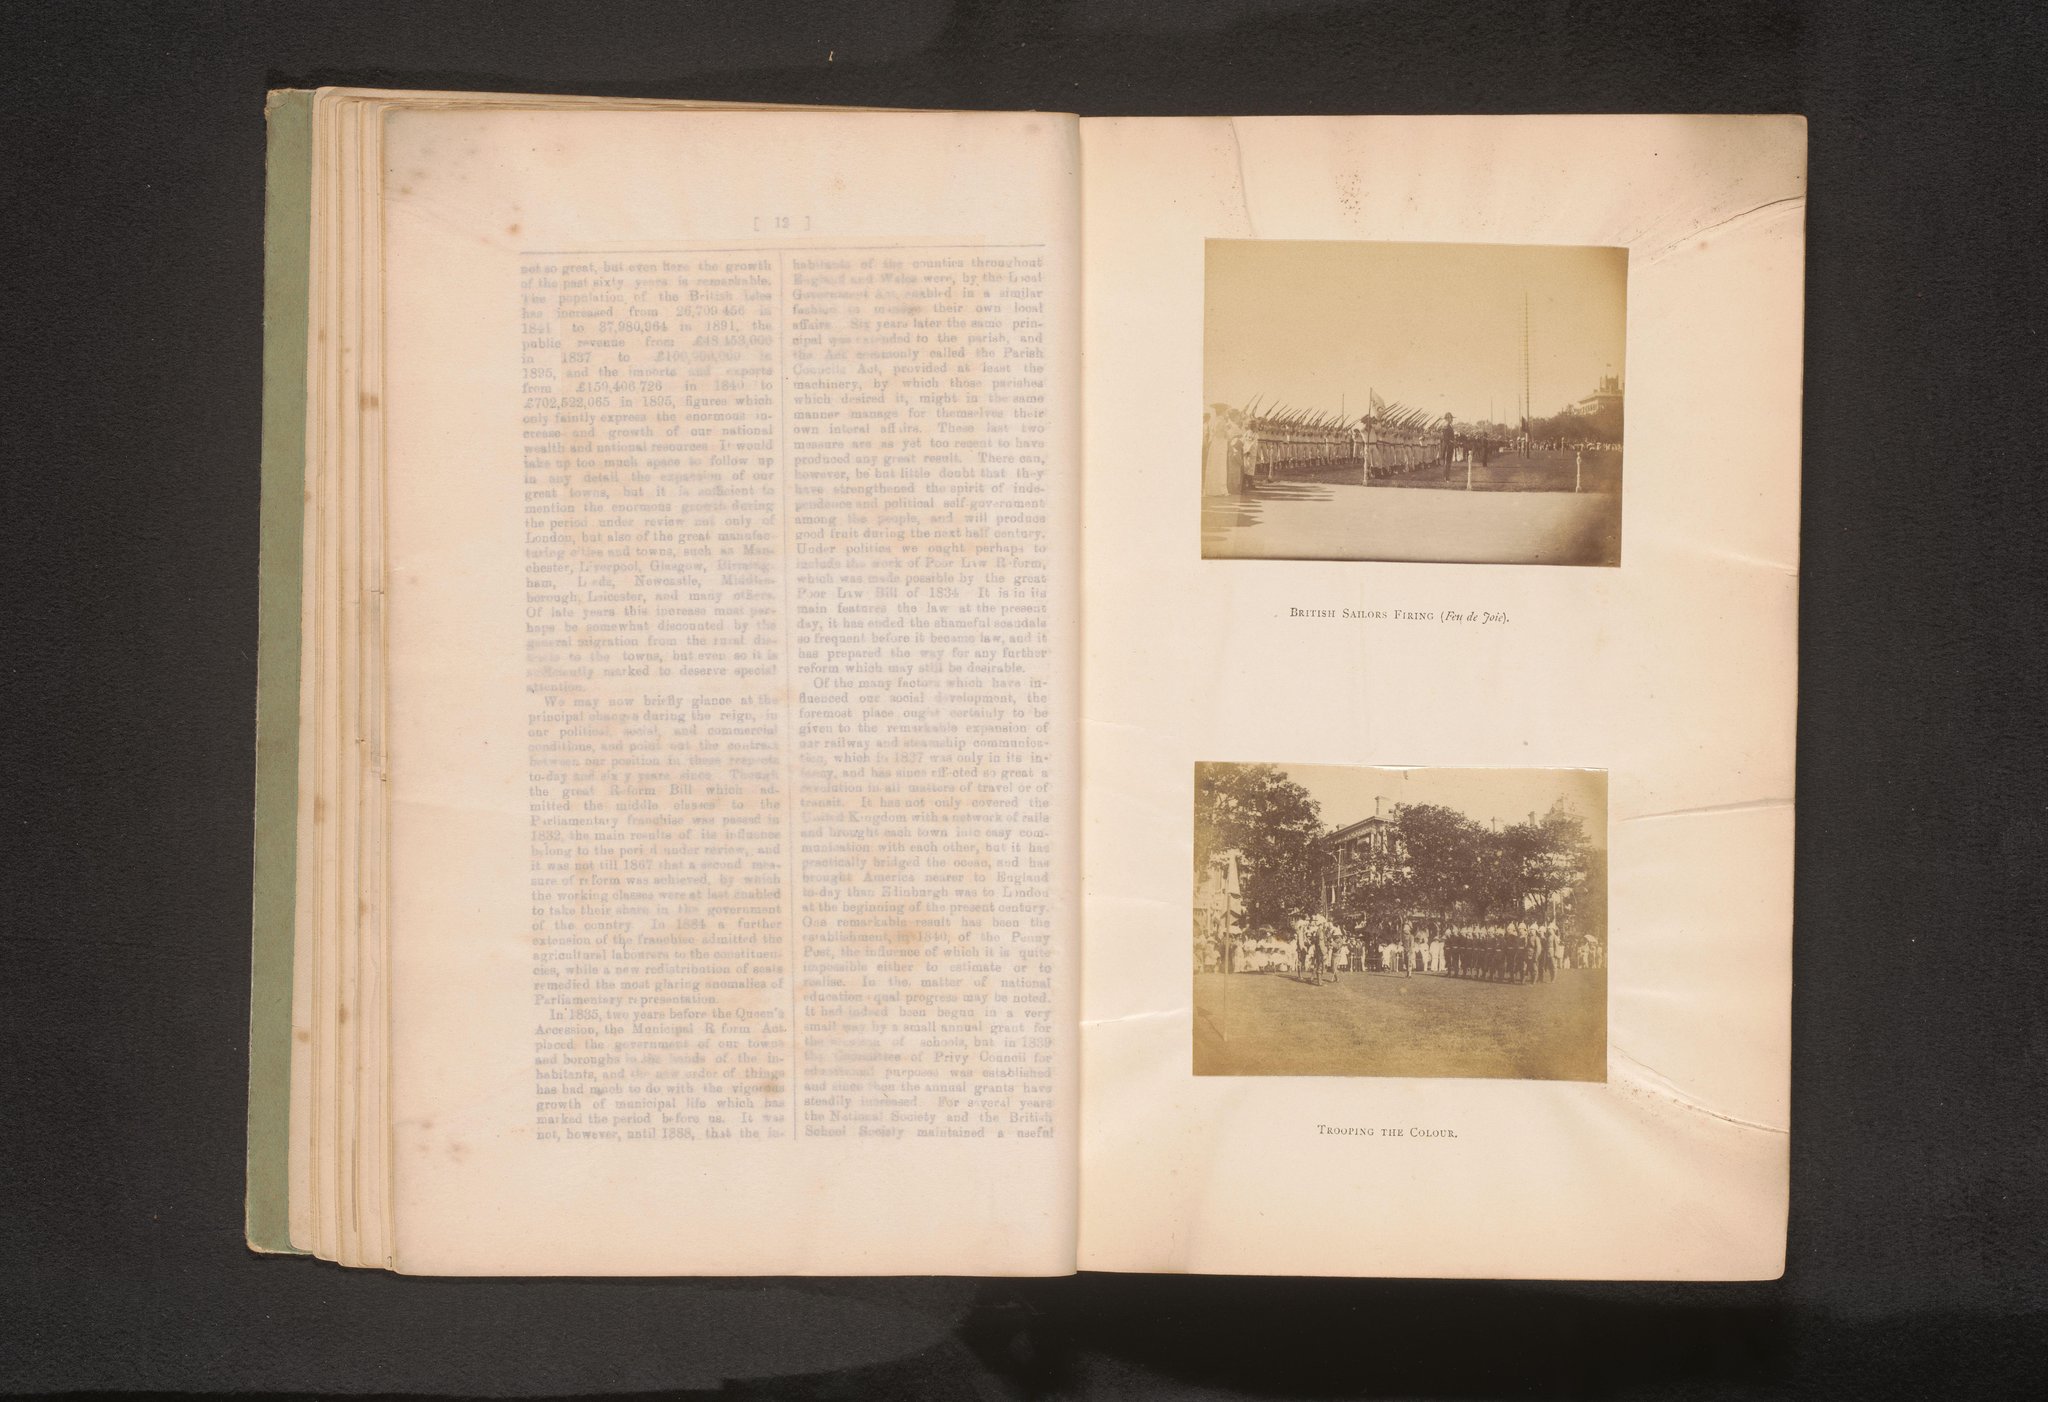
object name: photograph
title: British sailors firing (Feu de Joie). Trooping the colour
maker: w.r. kahler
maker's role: fotograaf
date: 1897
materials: photographic support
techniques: albumen print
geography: shanghai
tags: ruler saluted with gun-fire, sailor, commemoration, jubilee